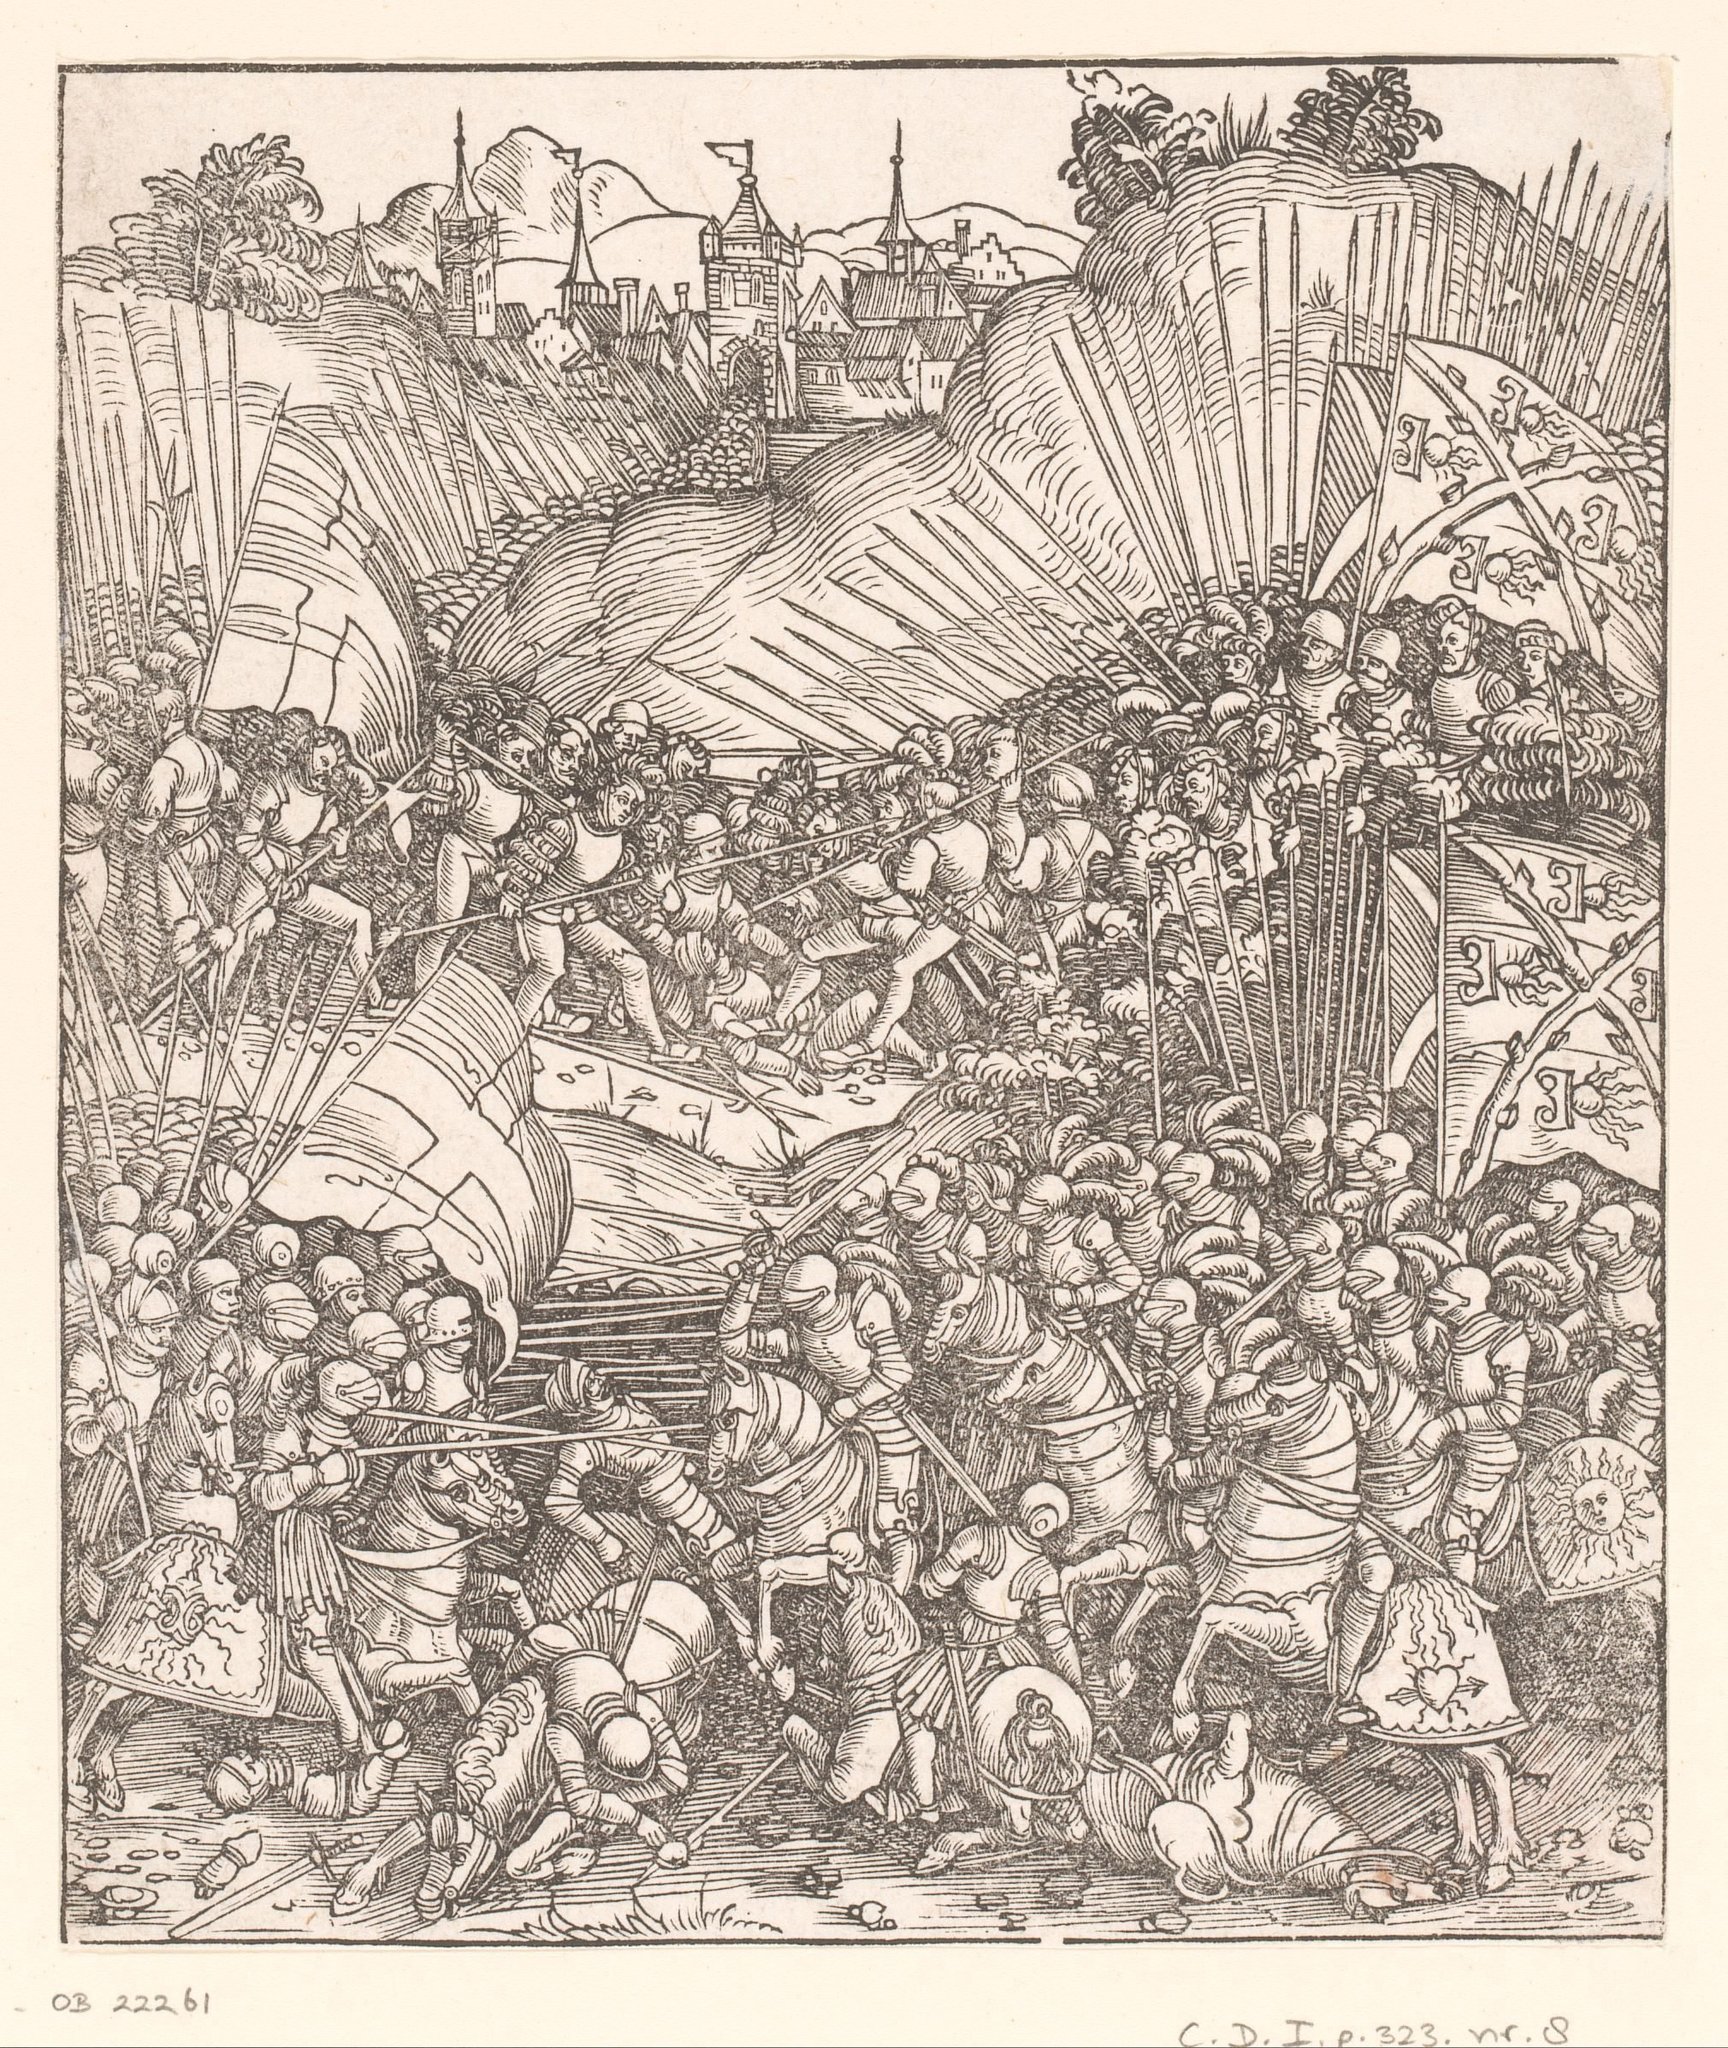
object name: print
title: Oorlog met Luik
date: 1515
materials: paper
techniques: woodcut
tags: maximilian i (holy roman emperor), siege, liège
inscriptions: collector's mark: Lugt 240